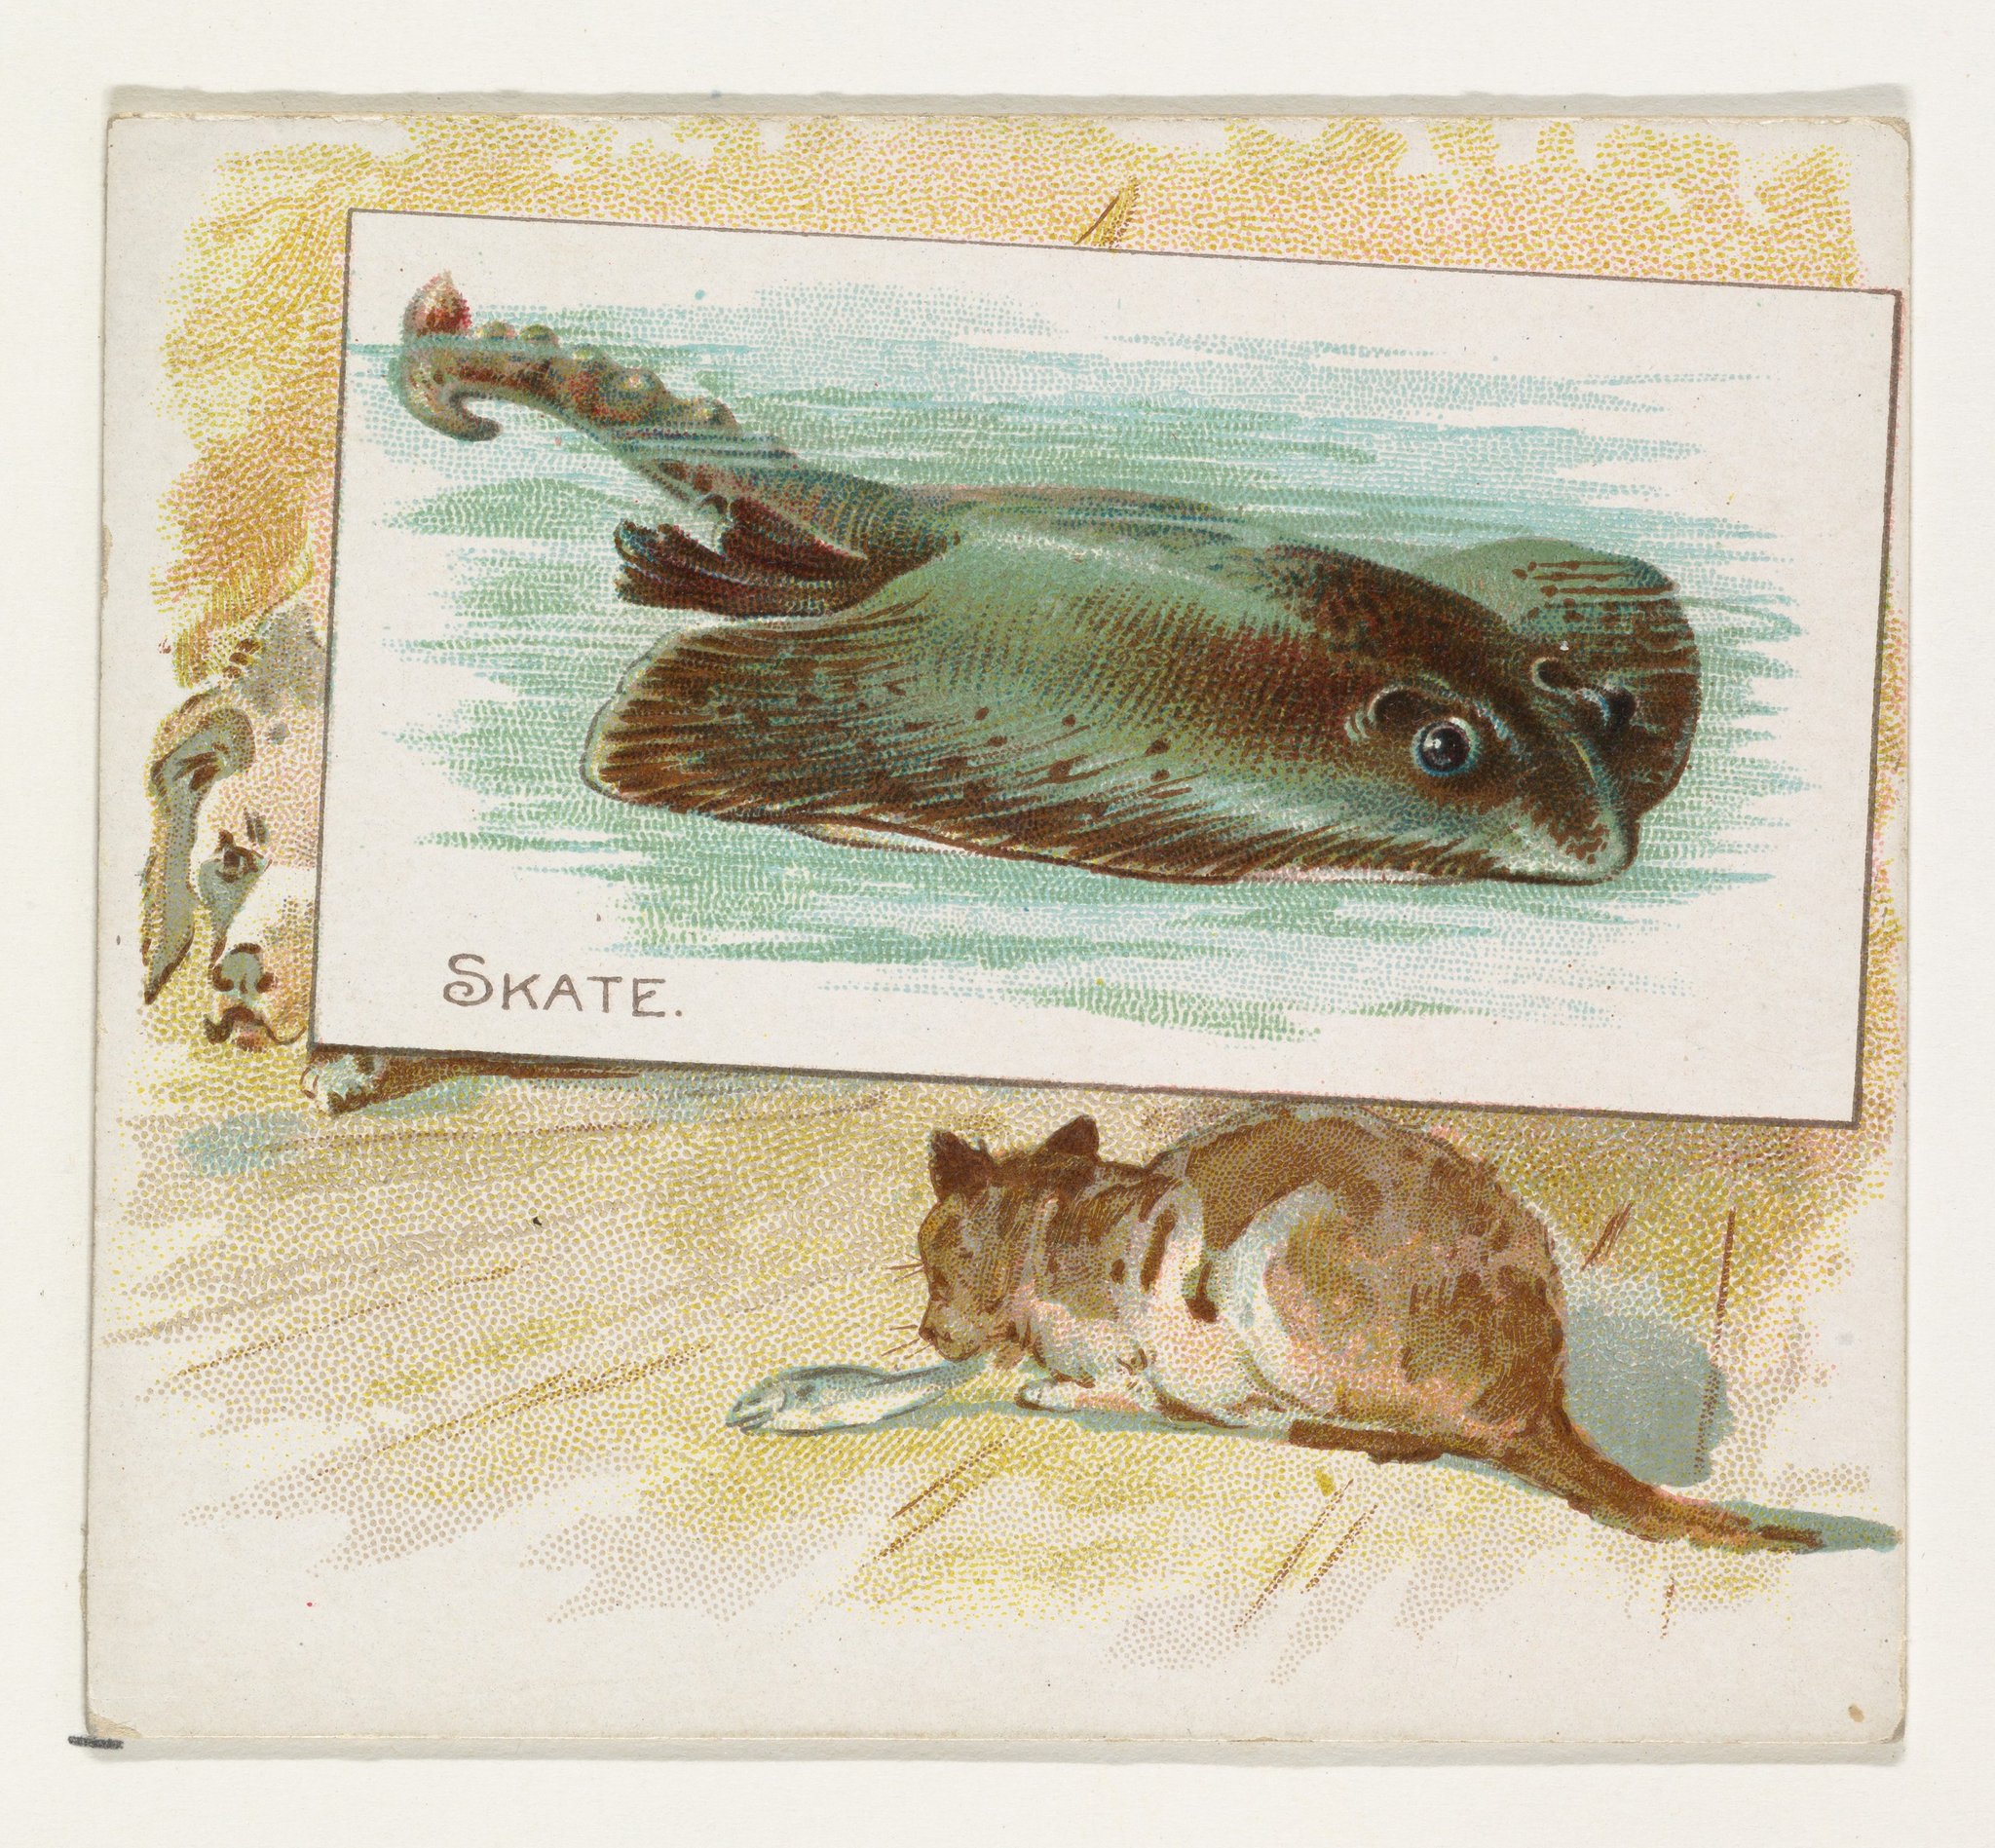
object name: print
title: Skate, from Fish from American Waters series (N39) for Allen & Ginter Cigarettes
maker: allen & ginter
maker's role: publisher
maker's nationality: american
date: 1889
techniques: color lithograph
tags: cats,fish